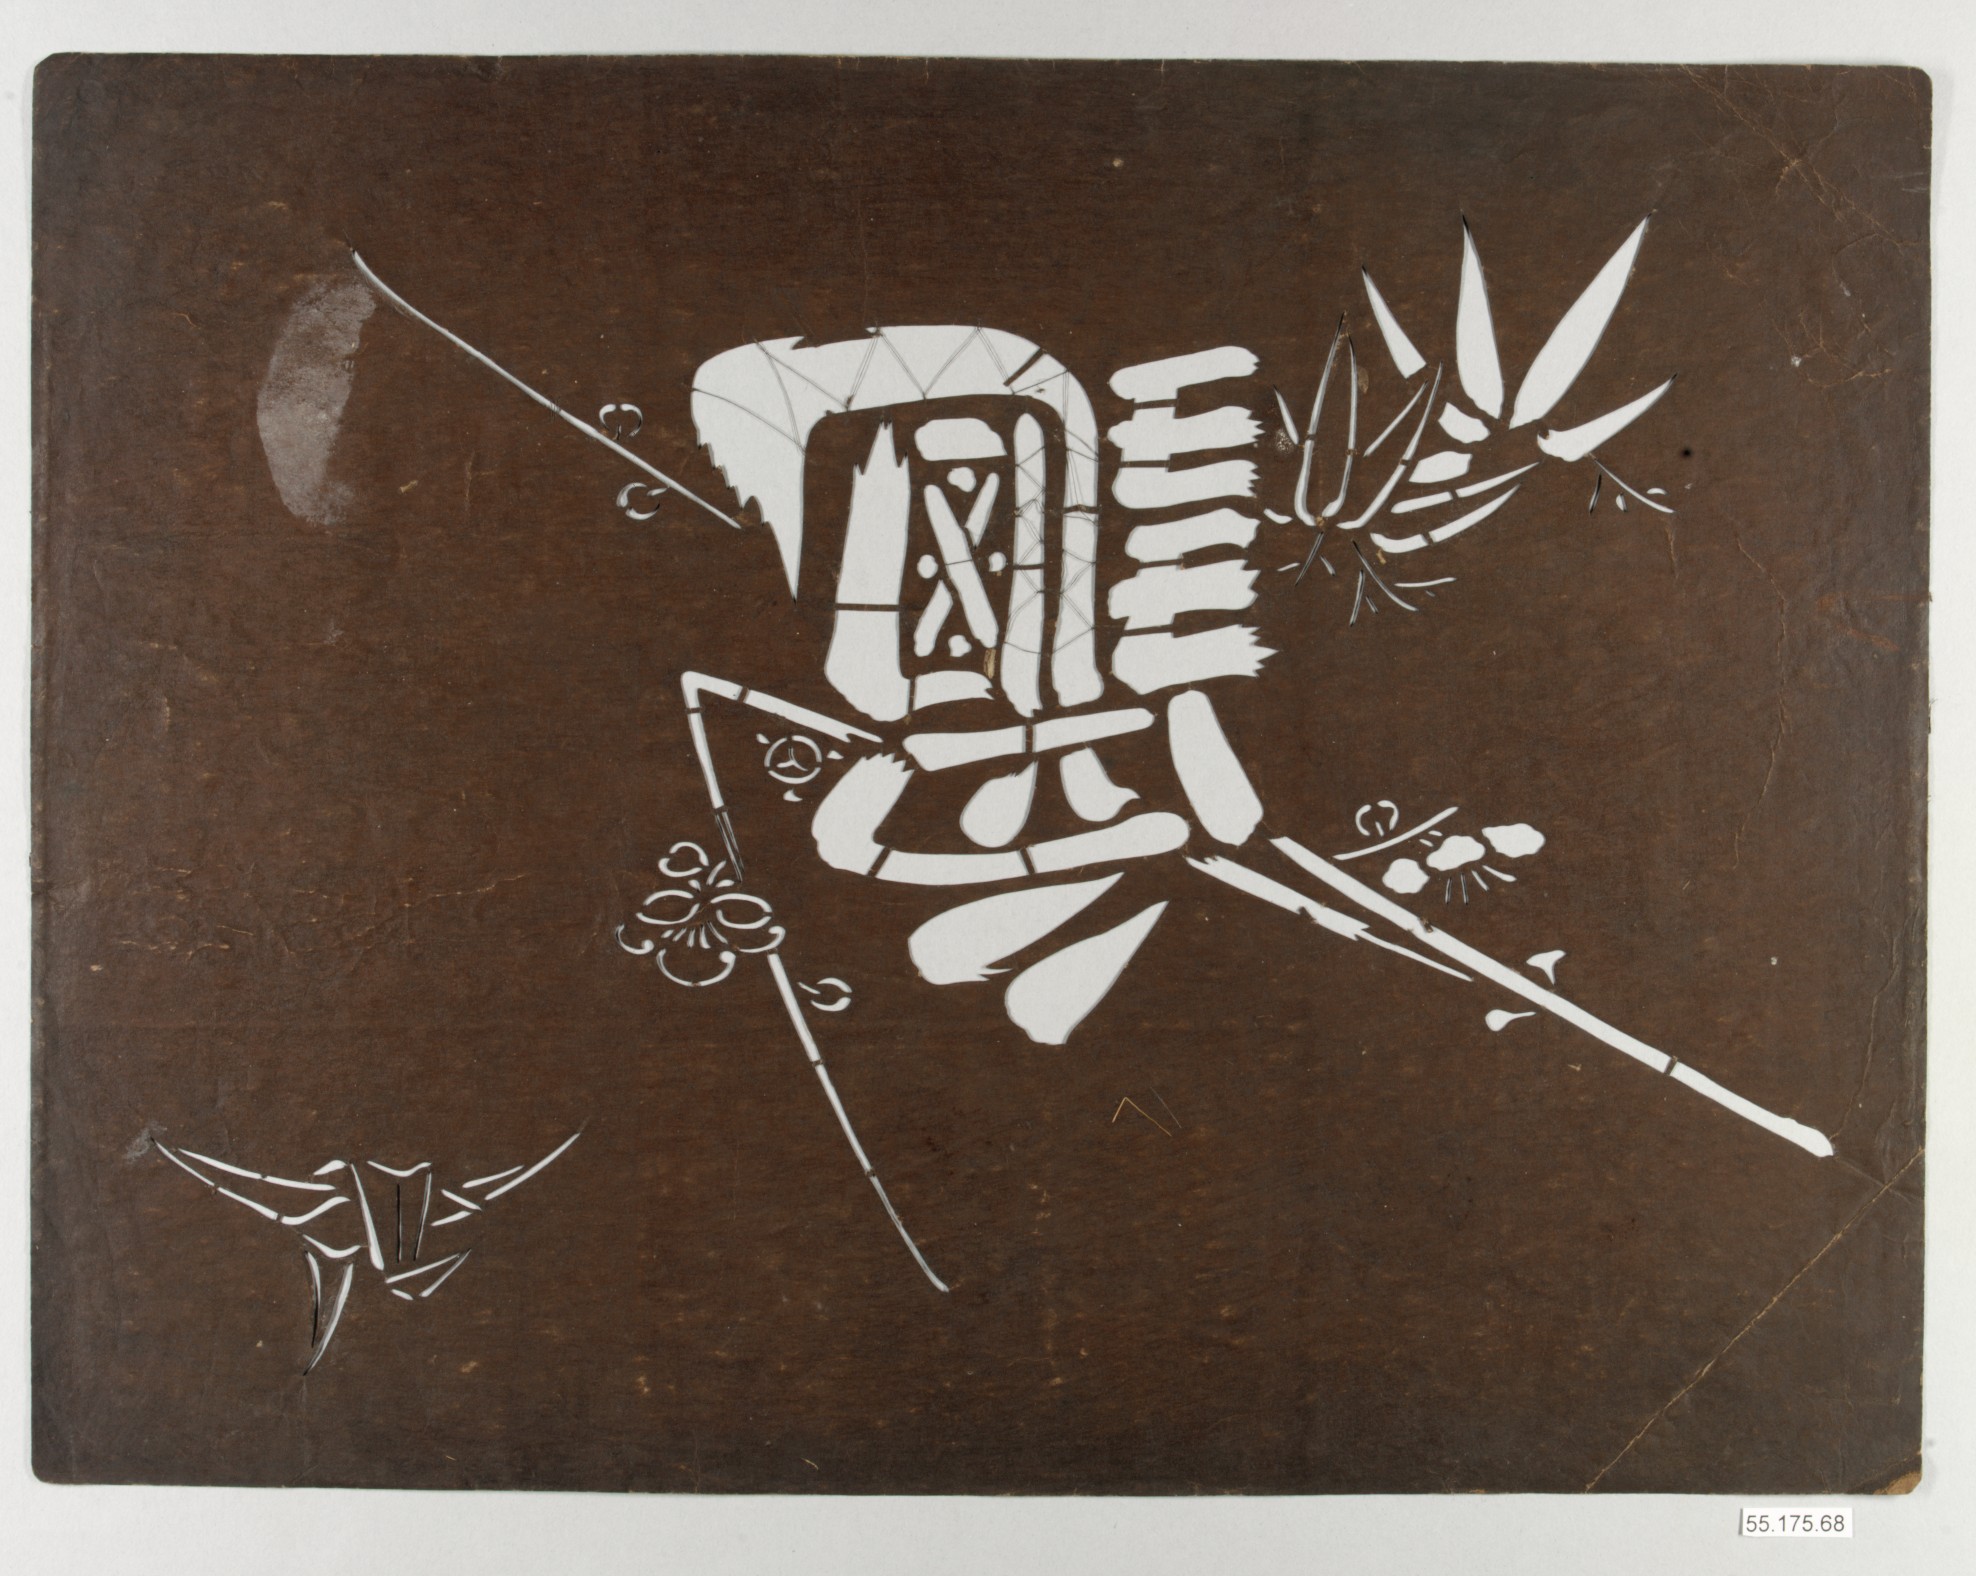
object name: stencil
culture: japanese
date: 1801-1900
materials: paper, silk